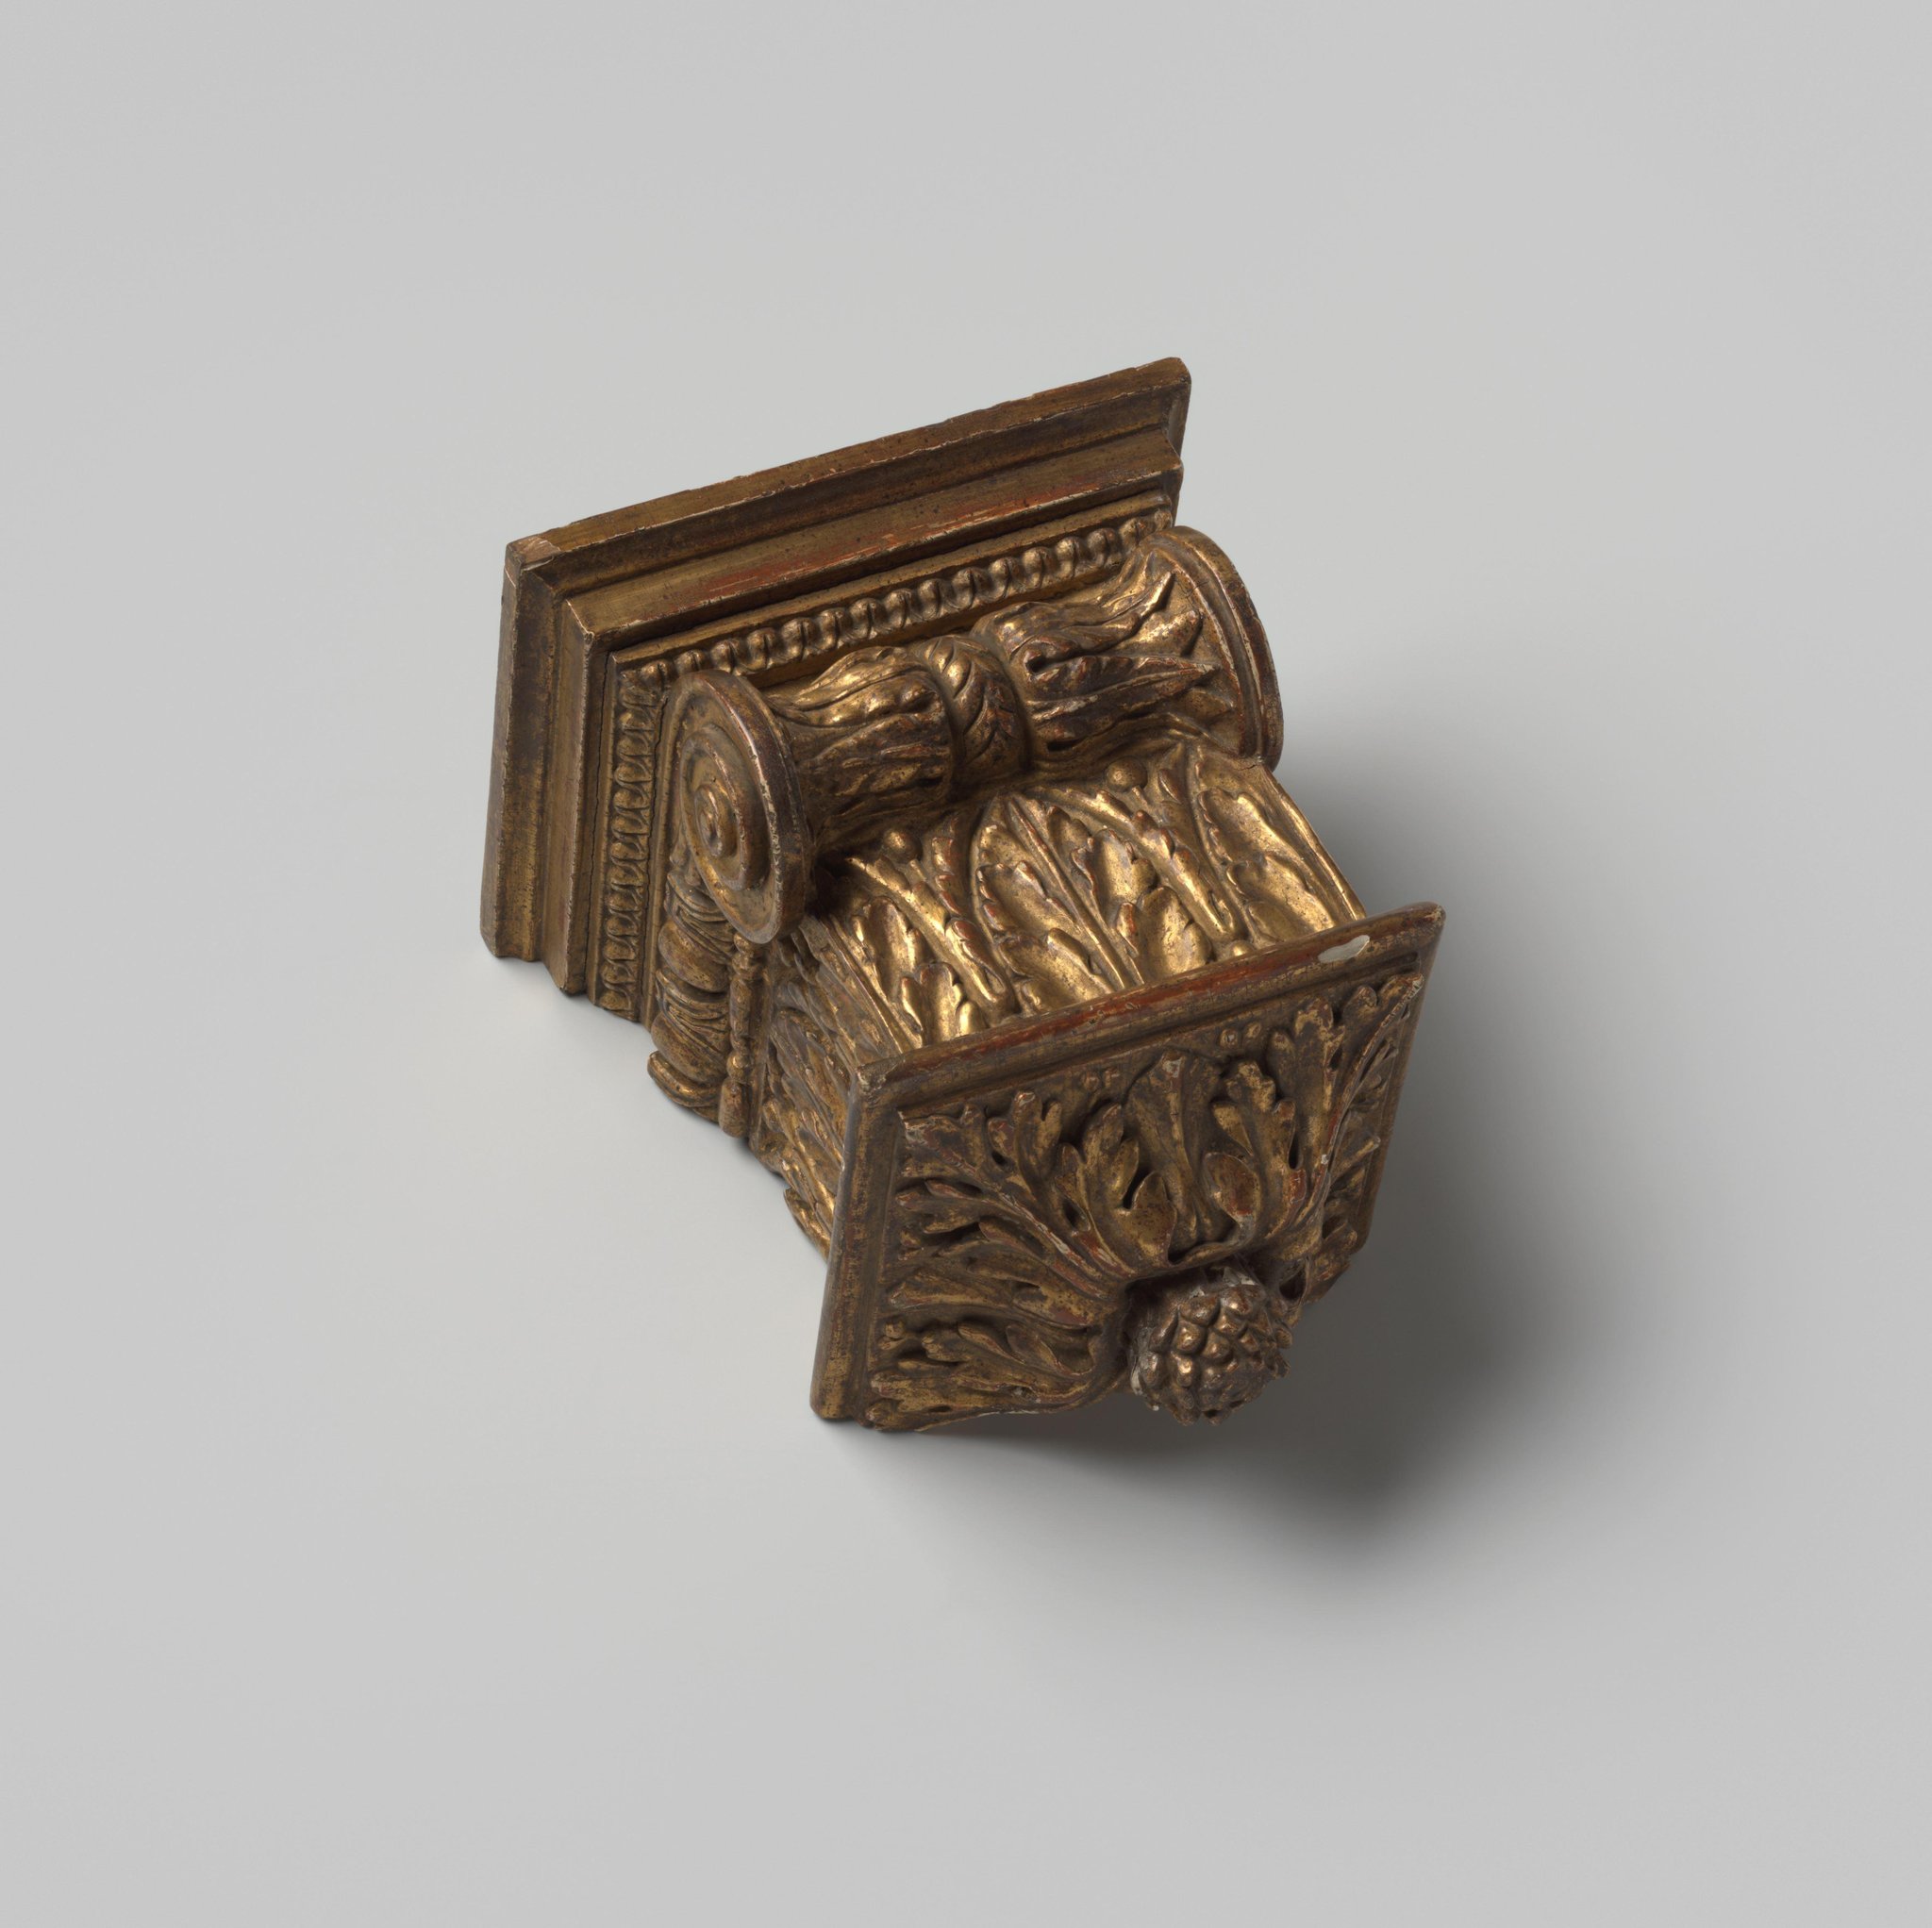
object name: architectural element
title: Console van eikenhout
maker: Anonymous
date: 1400-1499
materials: pigment, wood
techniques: gilding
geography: italy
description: Console van eikenhout, verguld op bolus. Het lichaam is een kubus, in reliëf besneden met acanthusblad en eindigend in een kapiteel van de Ionische orde, versierd met bladwerk en een forse eierlijst, waaronder een parellijst. De kubus staat op een uitspringende basis, welke aan de onderzijde taps toelopende acanthusbladeren vertoont, eindigend in een hangende granaatappel. De abacus bestaat uit drie geledingen, waarvan de onderste versierd is met een cumamotief.